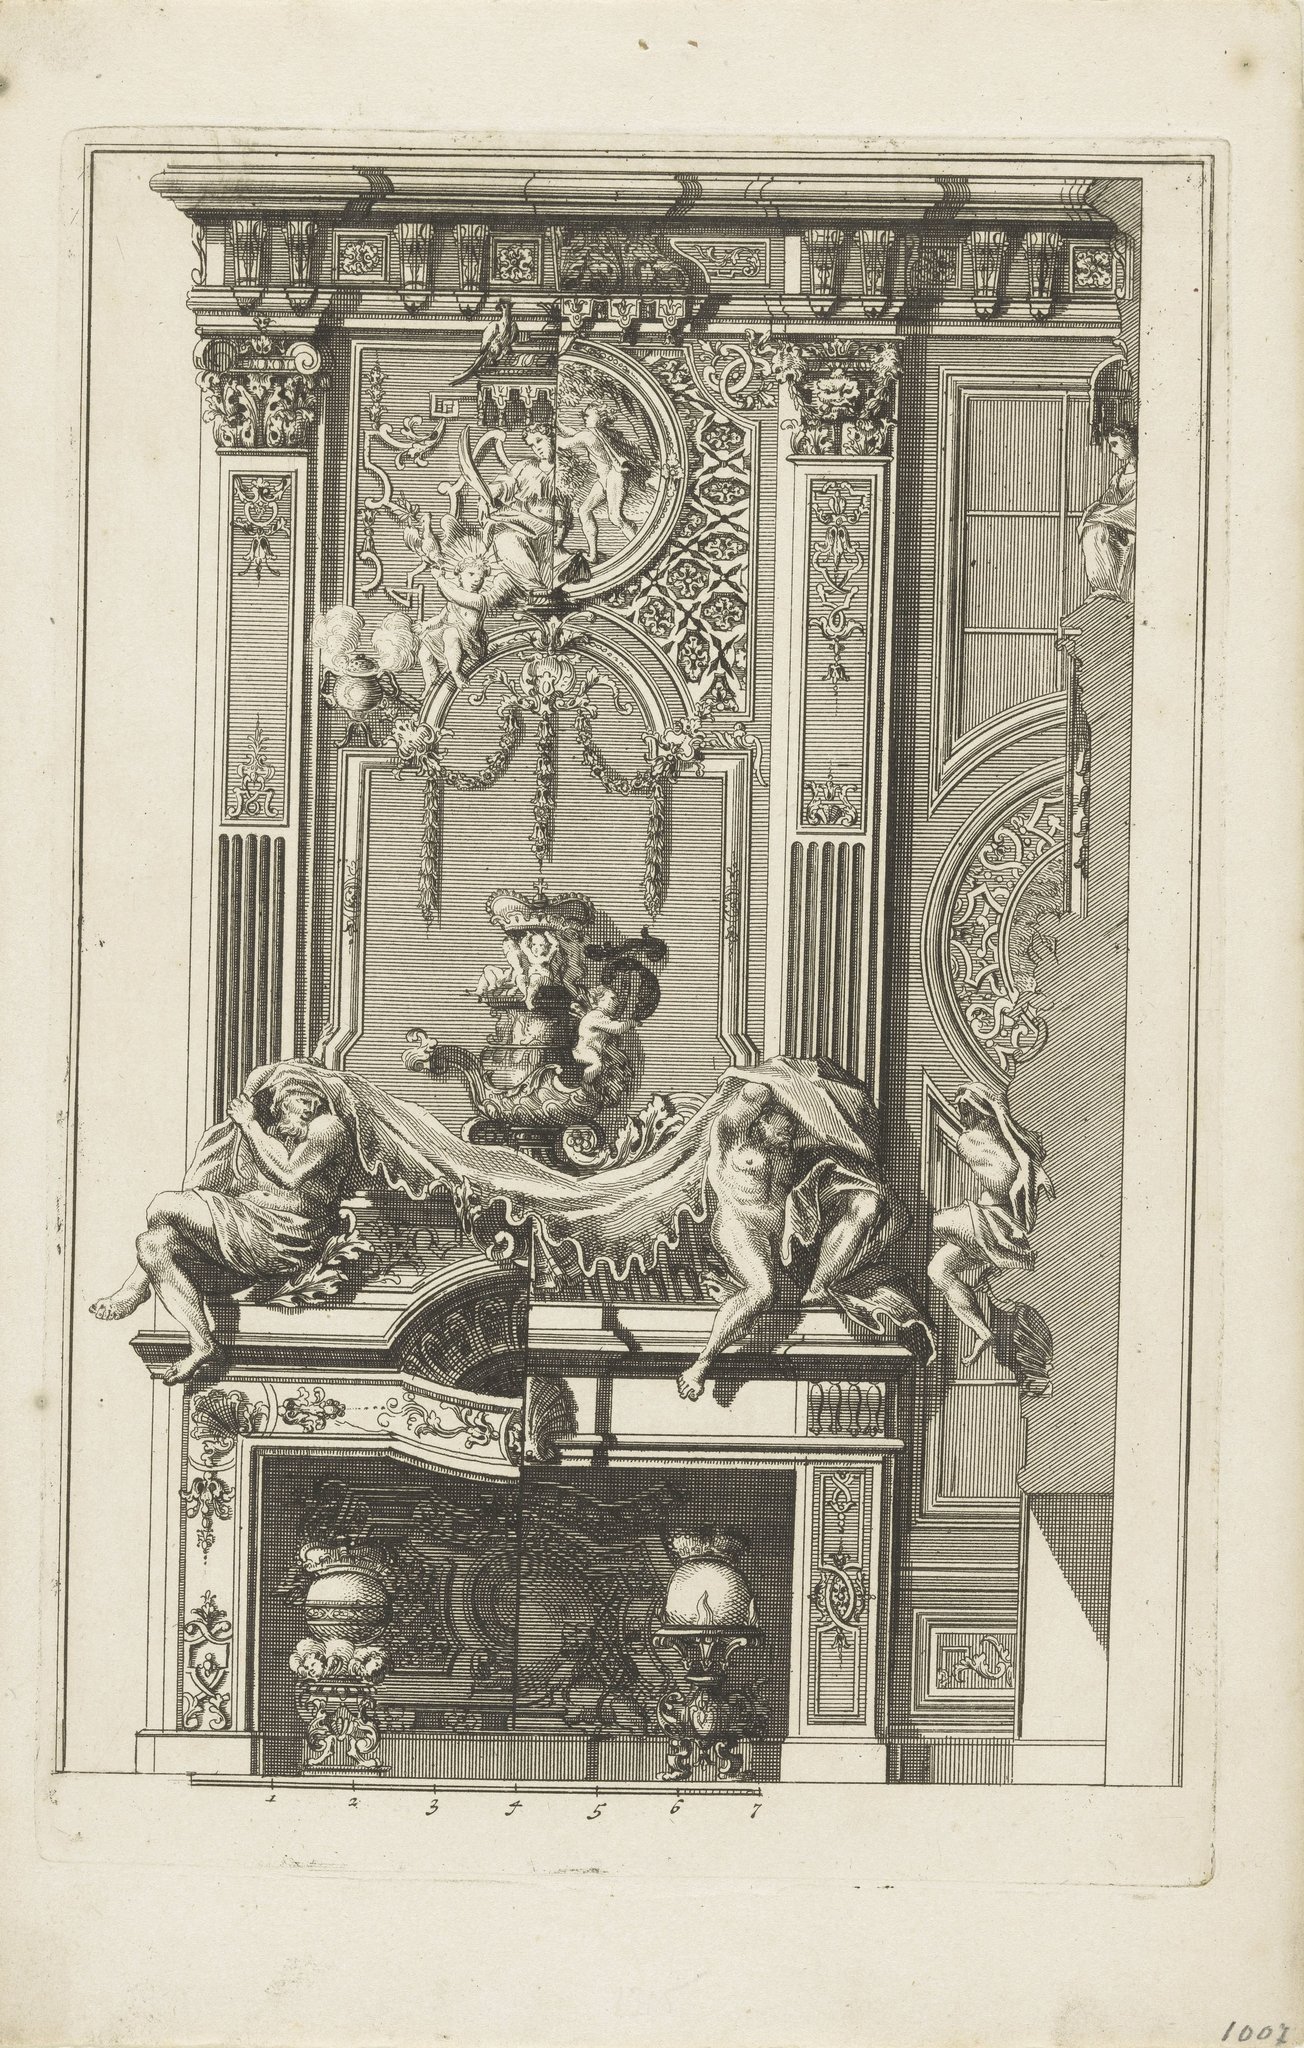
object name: print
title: Onderdelen van schoorsteenmantels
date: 1708-1724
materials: paper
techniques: etching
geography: nuremberg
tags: interior of the house, chimney-piece, mantelpiece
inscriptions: collector's mark: Lugt 2228, collector's mark: Lugt 2760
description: Gedecoreerd met grotesken, festoenen, vrouwen- en mannenfiguren.